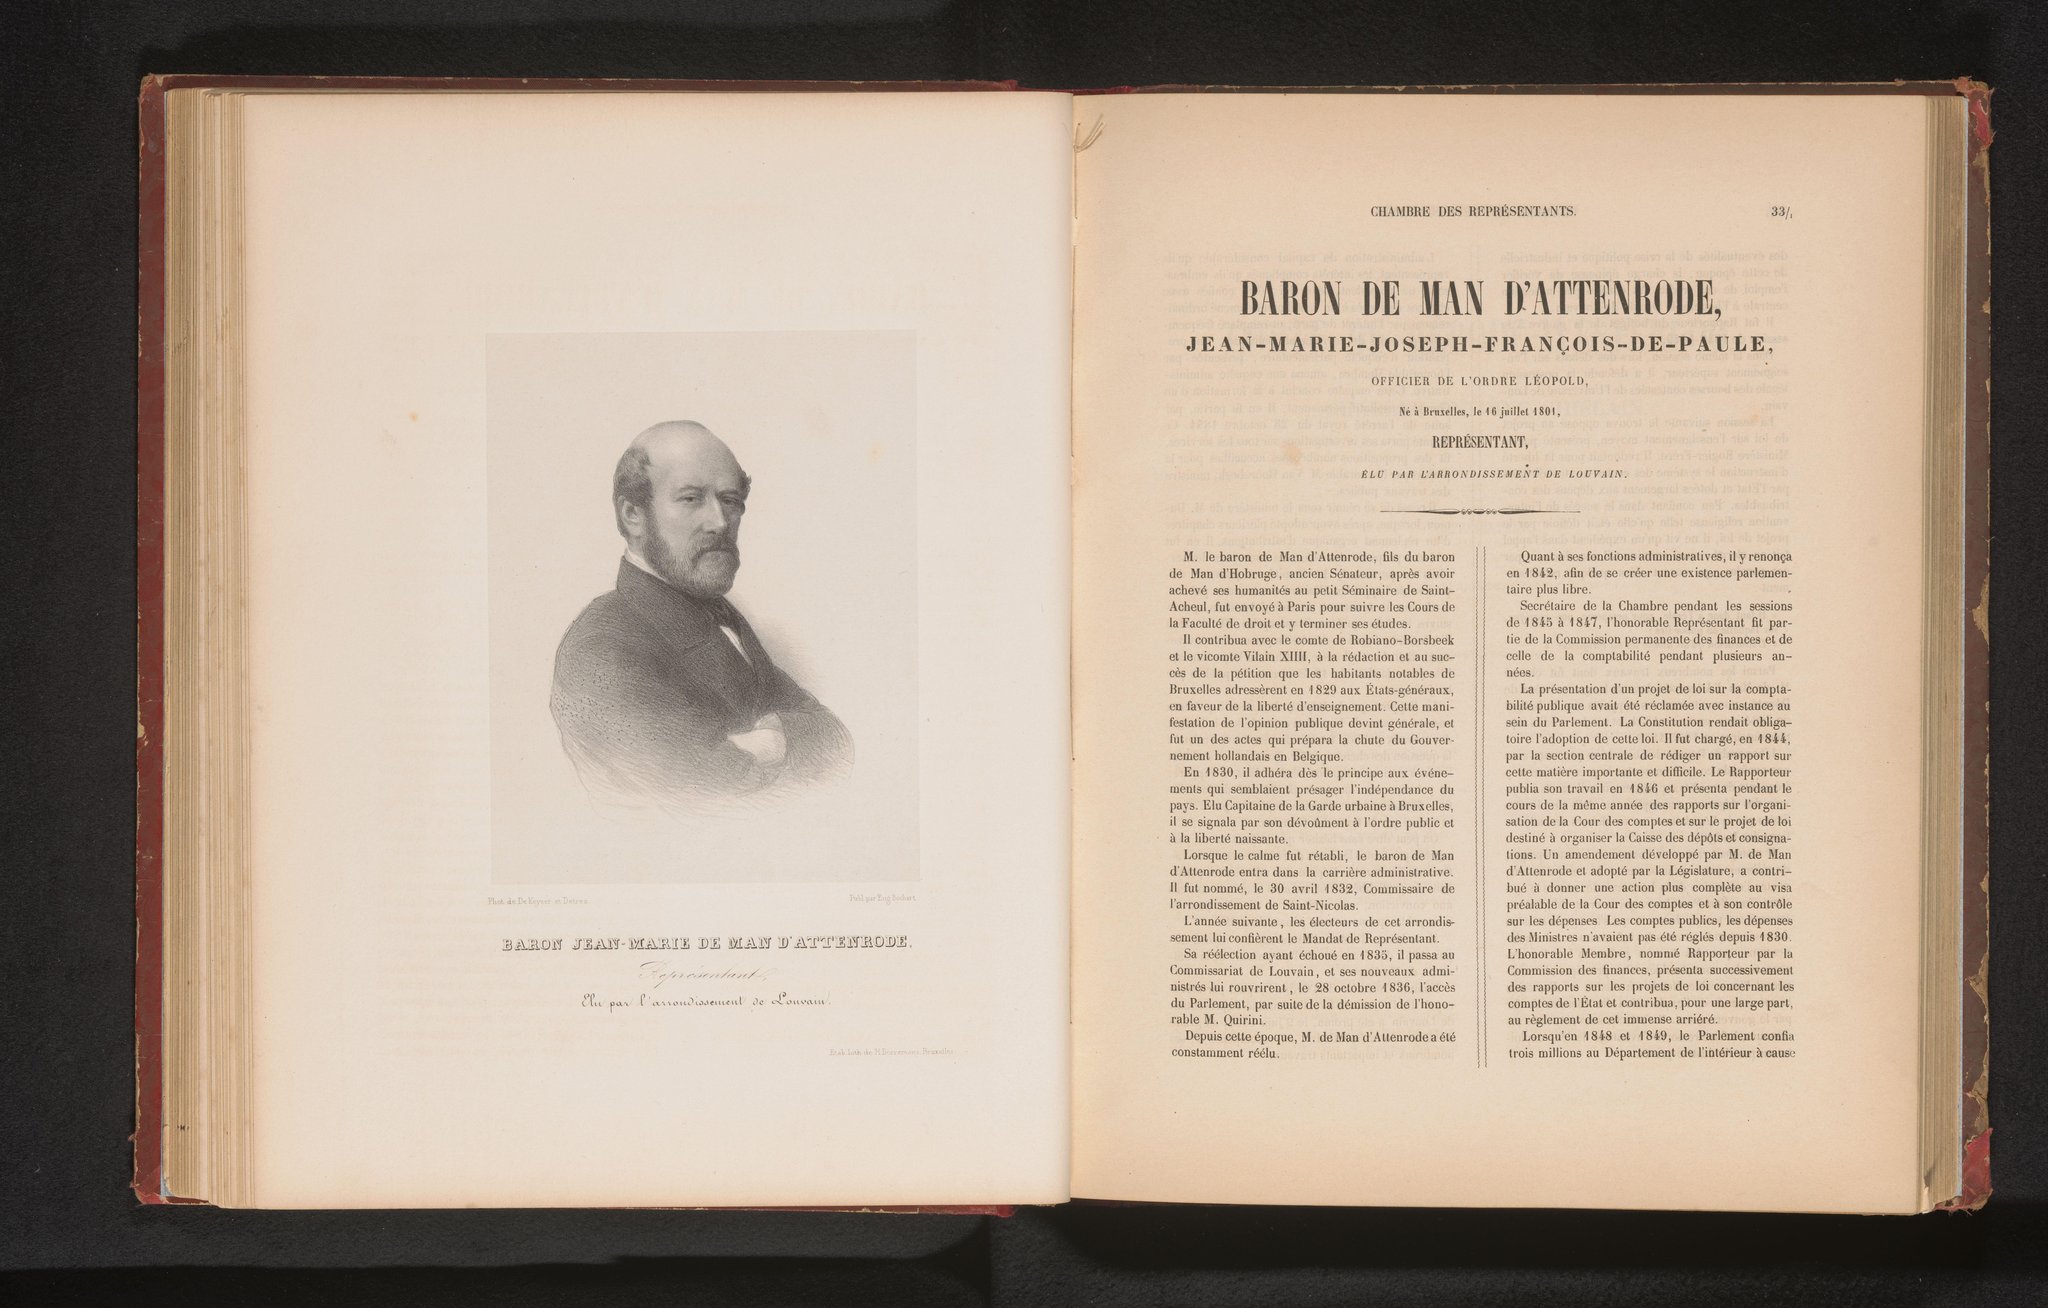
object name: reproduction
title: Baron Jean-Marie de Man d'Attenrode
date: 1853-1858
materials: paper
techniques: lithograph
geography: brussels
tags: politician, historical persons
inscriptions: inscription: ‘Représentant,/ Elu par l'arrondissement de Louvain.’